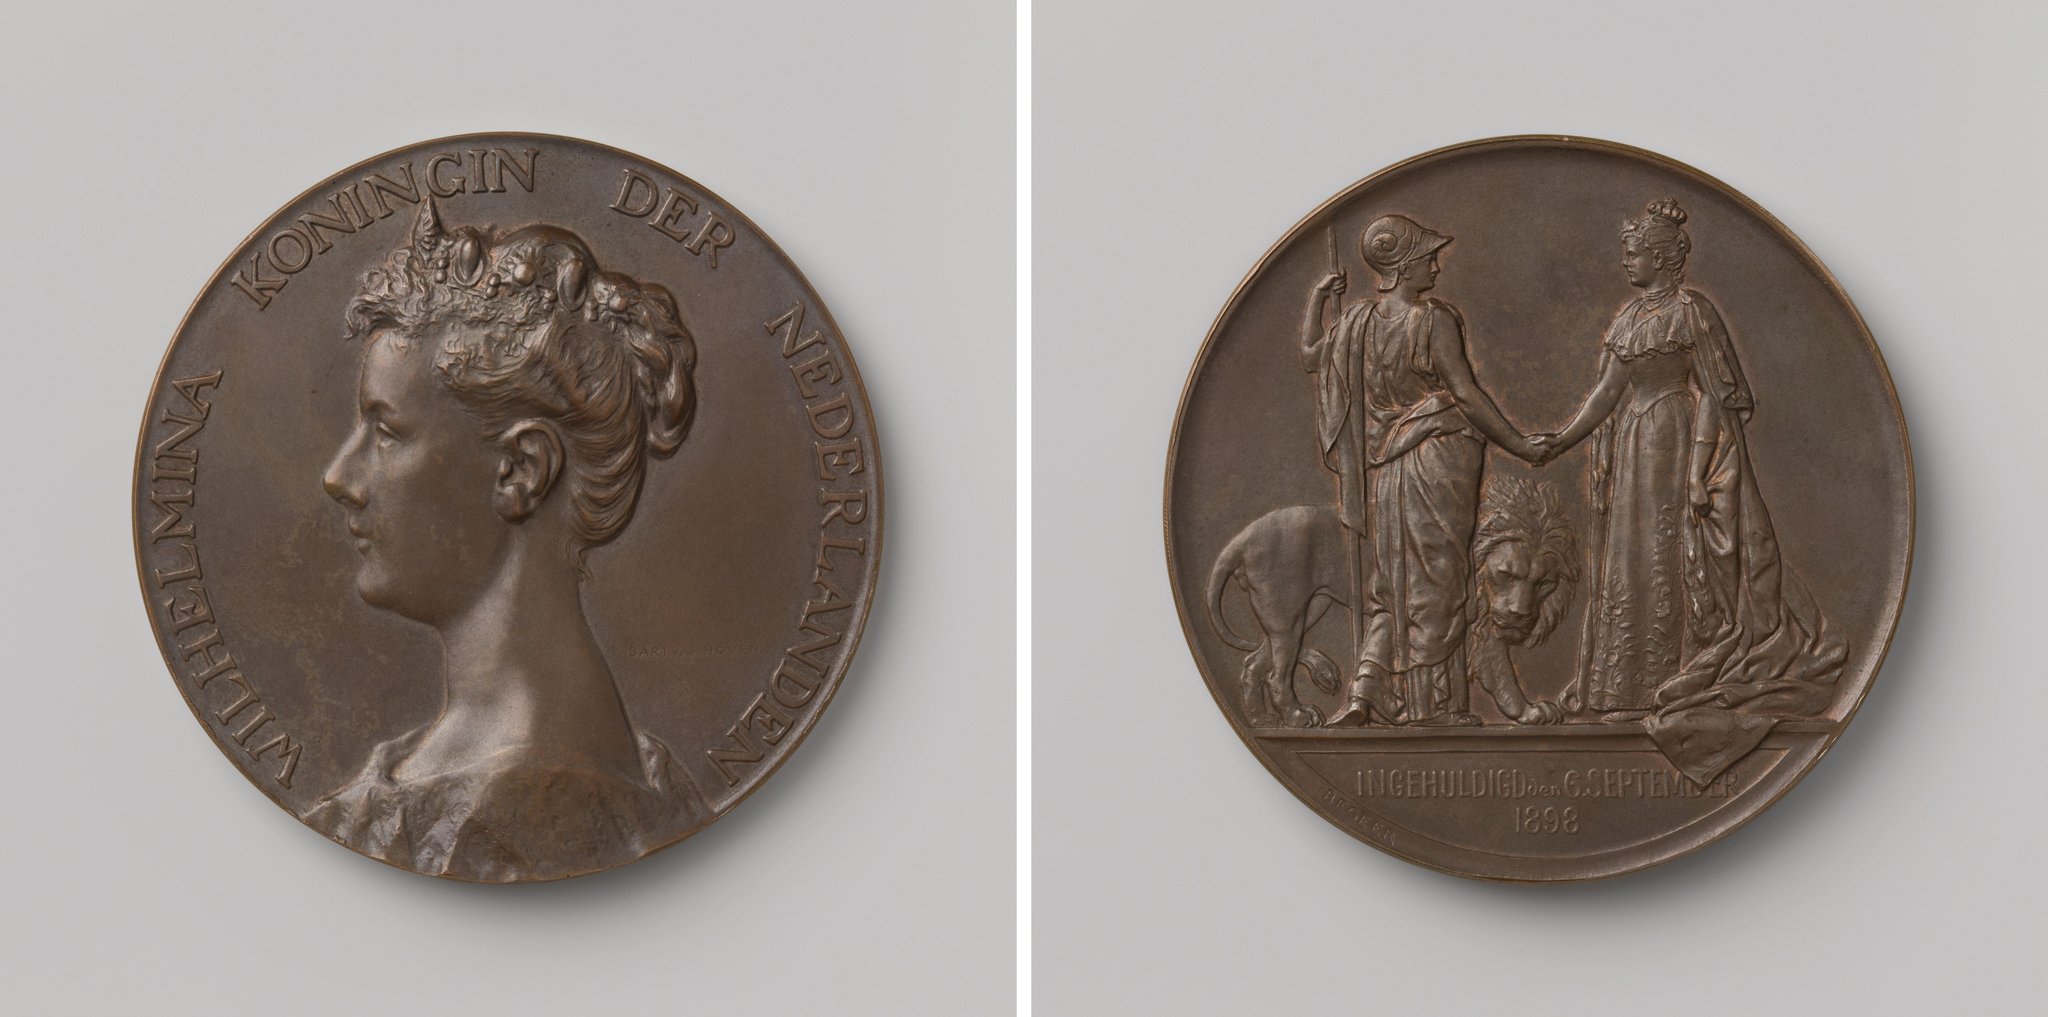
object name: history medal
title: Inhuldiging van Wilhelmina, koningin der Nederlanden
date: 1898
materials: bronze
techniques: striking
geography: paris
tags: print maker, wilhelmina of the netherlands, netherlands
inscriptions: circumscription: ‘WILHELMINA KONINGIN DER NEDERLANDEN’, inscription: ‘INGEHULDIGD den 6 . SEPTEMBER 1898’, mark: ‘BART VAN HOVEN’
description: In brons 1130 exx. vervaanrdigd (zilver: 482).